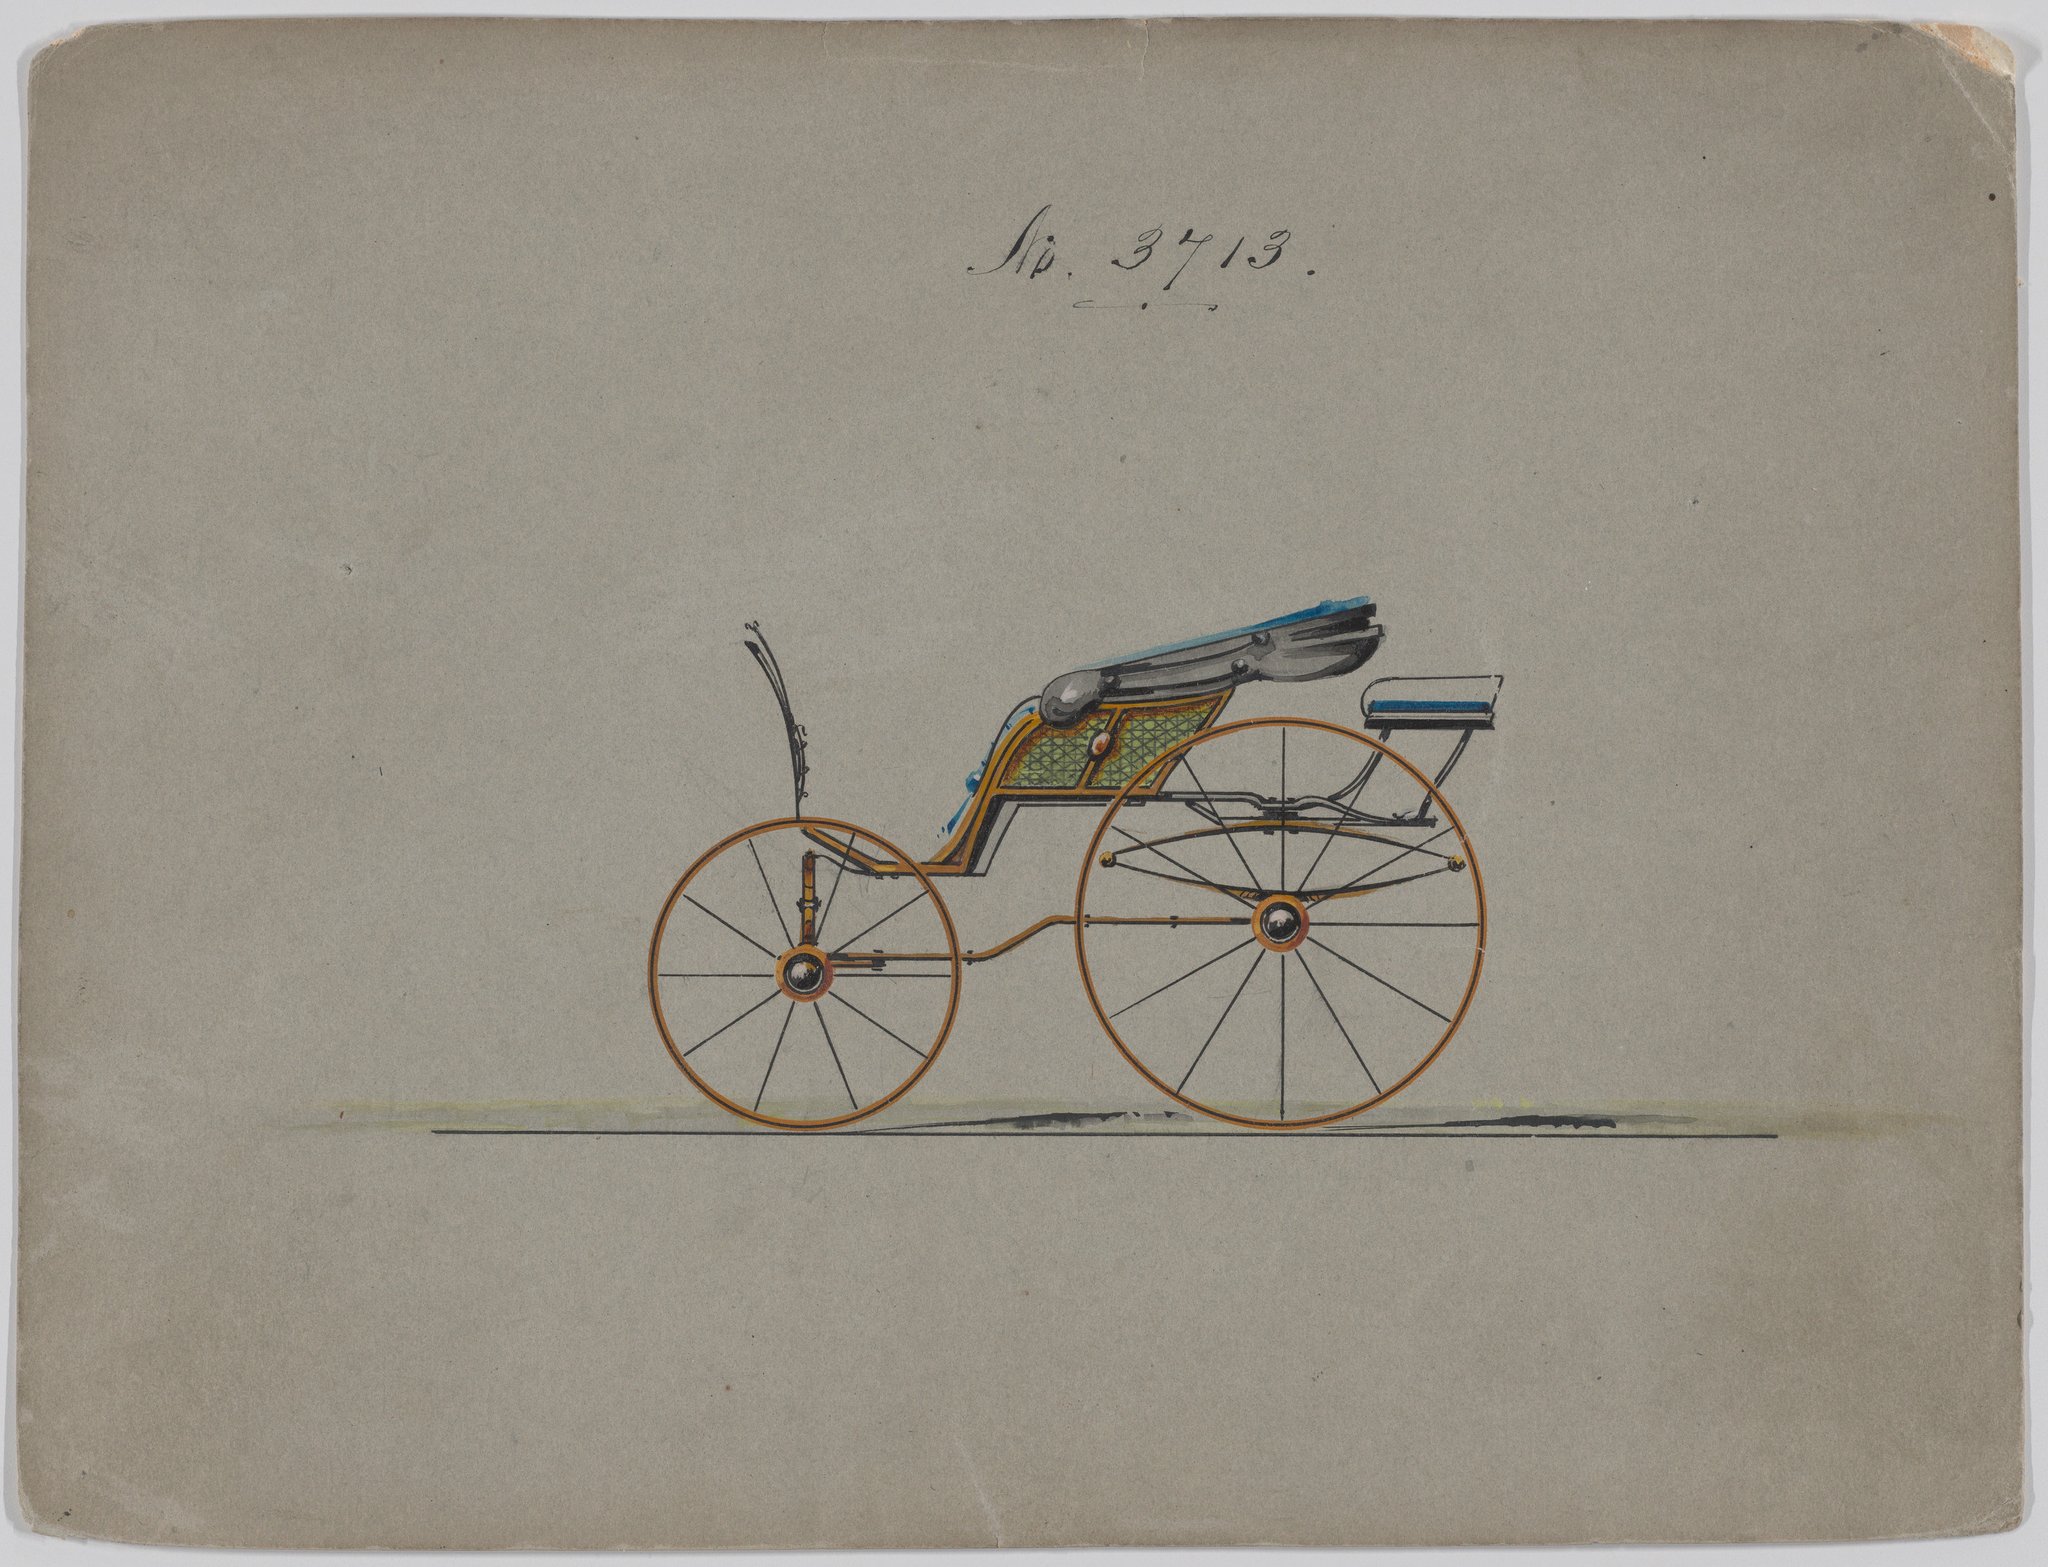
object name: drawing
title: Design for Pony Phaeton, no. 3713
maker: brewster & co.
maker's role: manufacturer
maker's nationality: american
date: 1881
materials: gouache, gum arabic, ink, watercolor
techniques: pen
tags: carriages